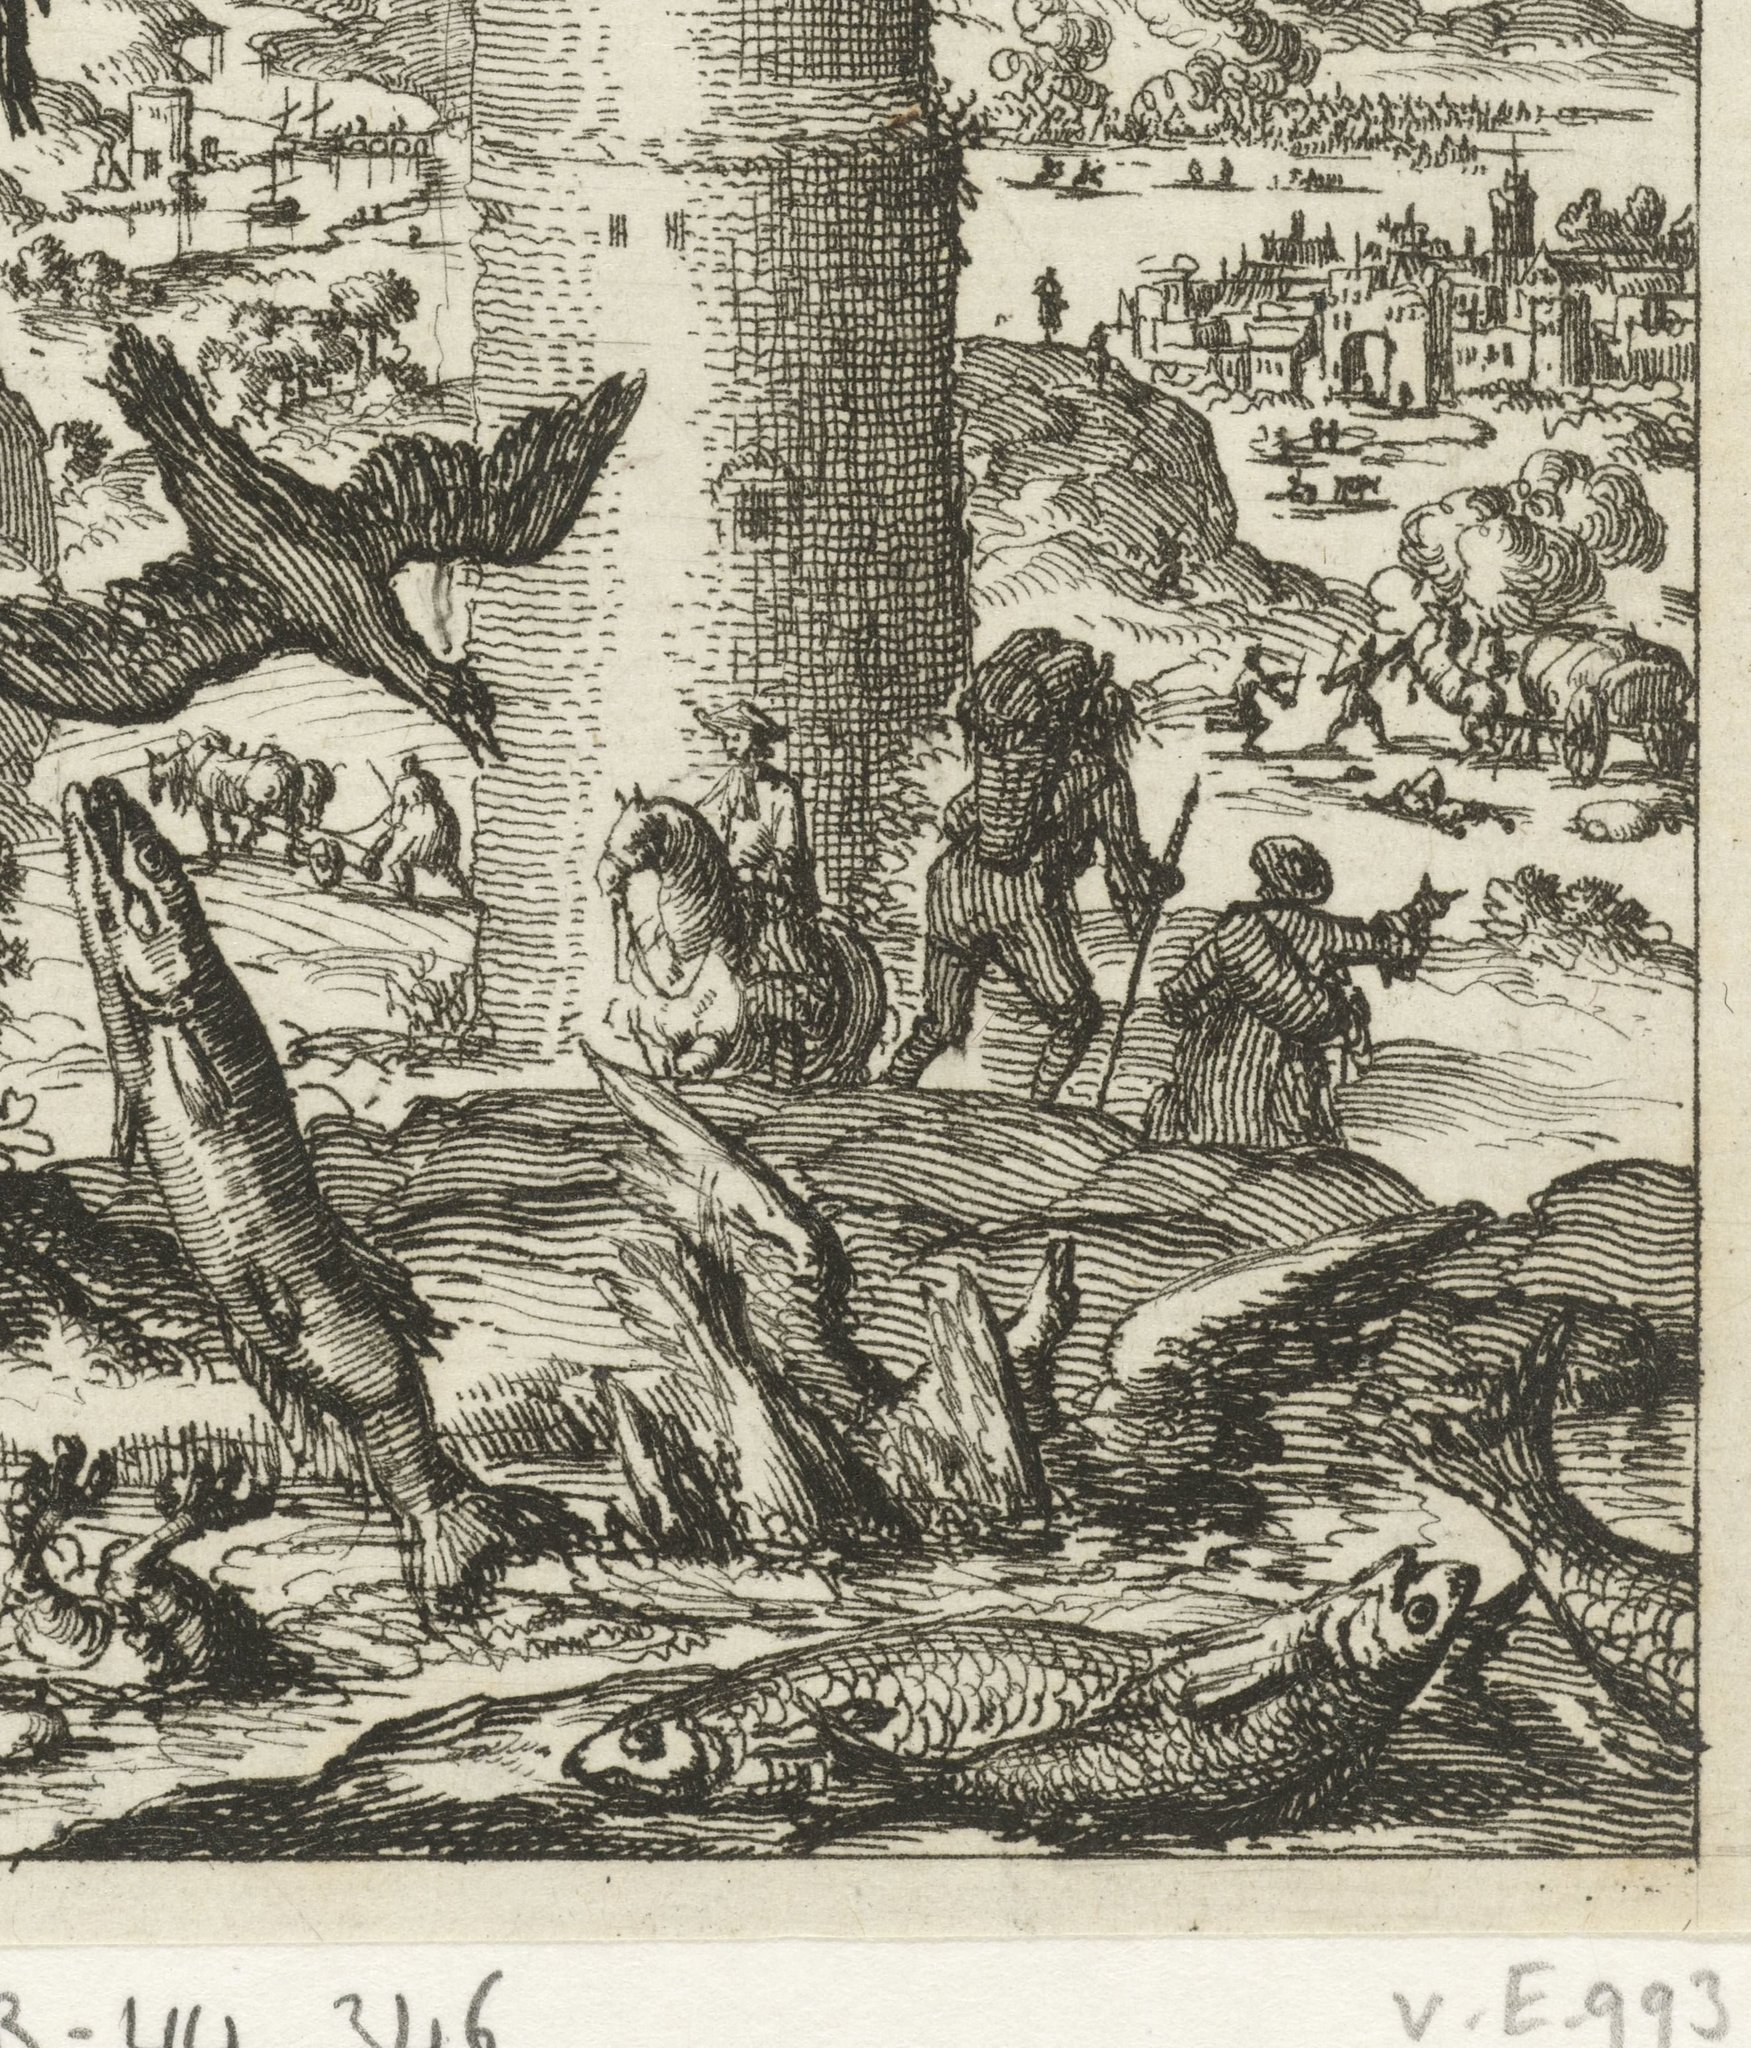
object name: book illustration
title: Vissen happen op het droge naar lucht, op de achtergrond een man op een hoge toren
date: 1689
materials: paper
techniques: etching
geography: amsterdam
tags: tower, clock tower ~ monumental adornment, fishes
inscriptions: collector's mark: Lugt 2228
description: Illustratie uit: Huygen, Pieter. De beginselen van Gods koninkryk in den mensch uitgedrukt in zinnebeelden. Amsterdam: wed. Arentsz. Pieter (II), 1689, p. 8.